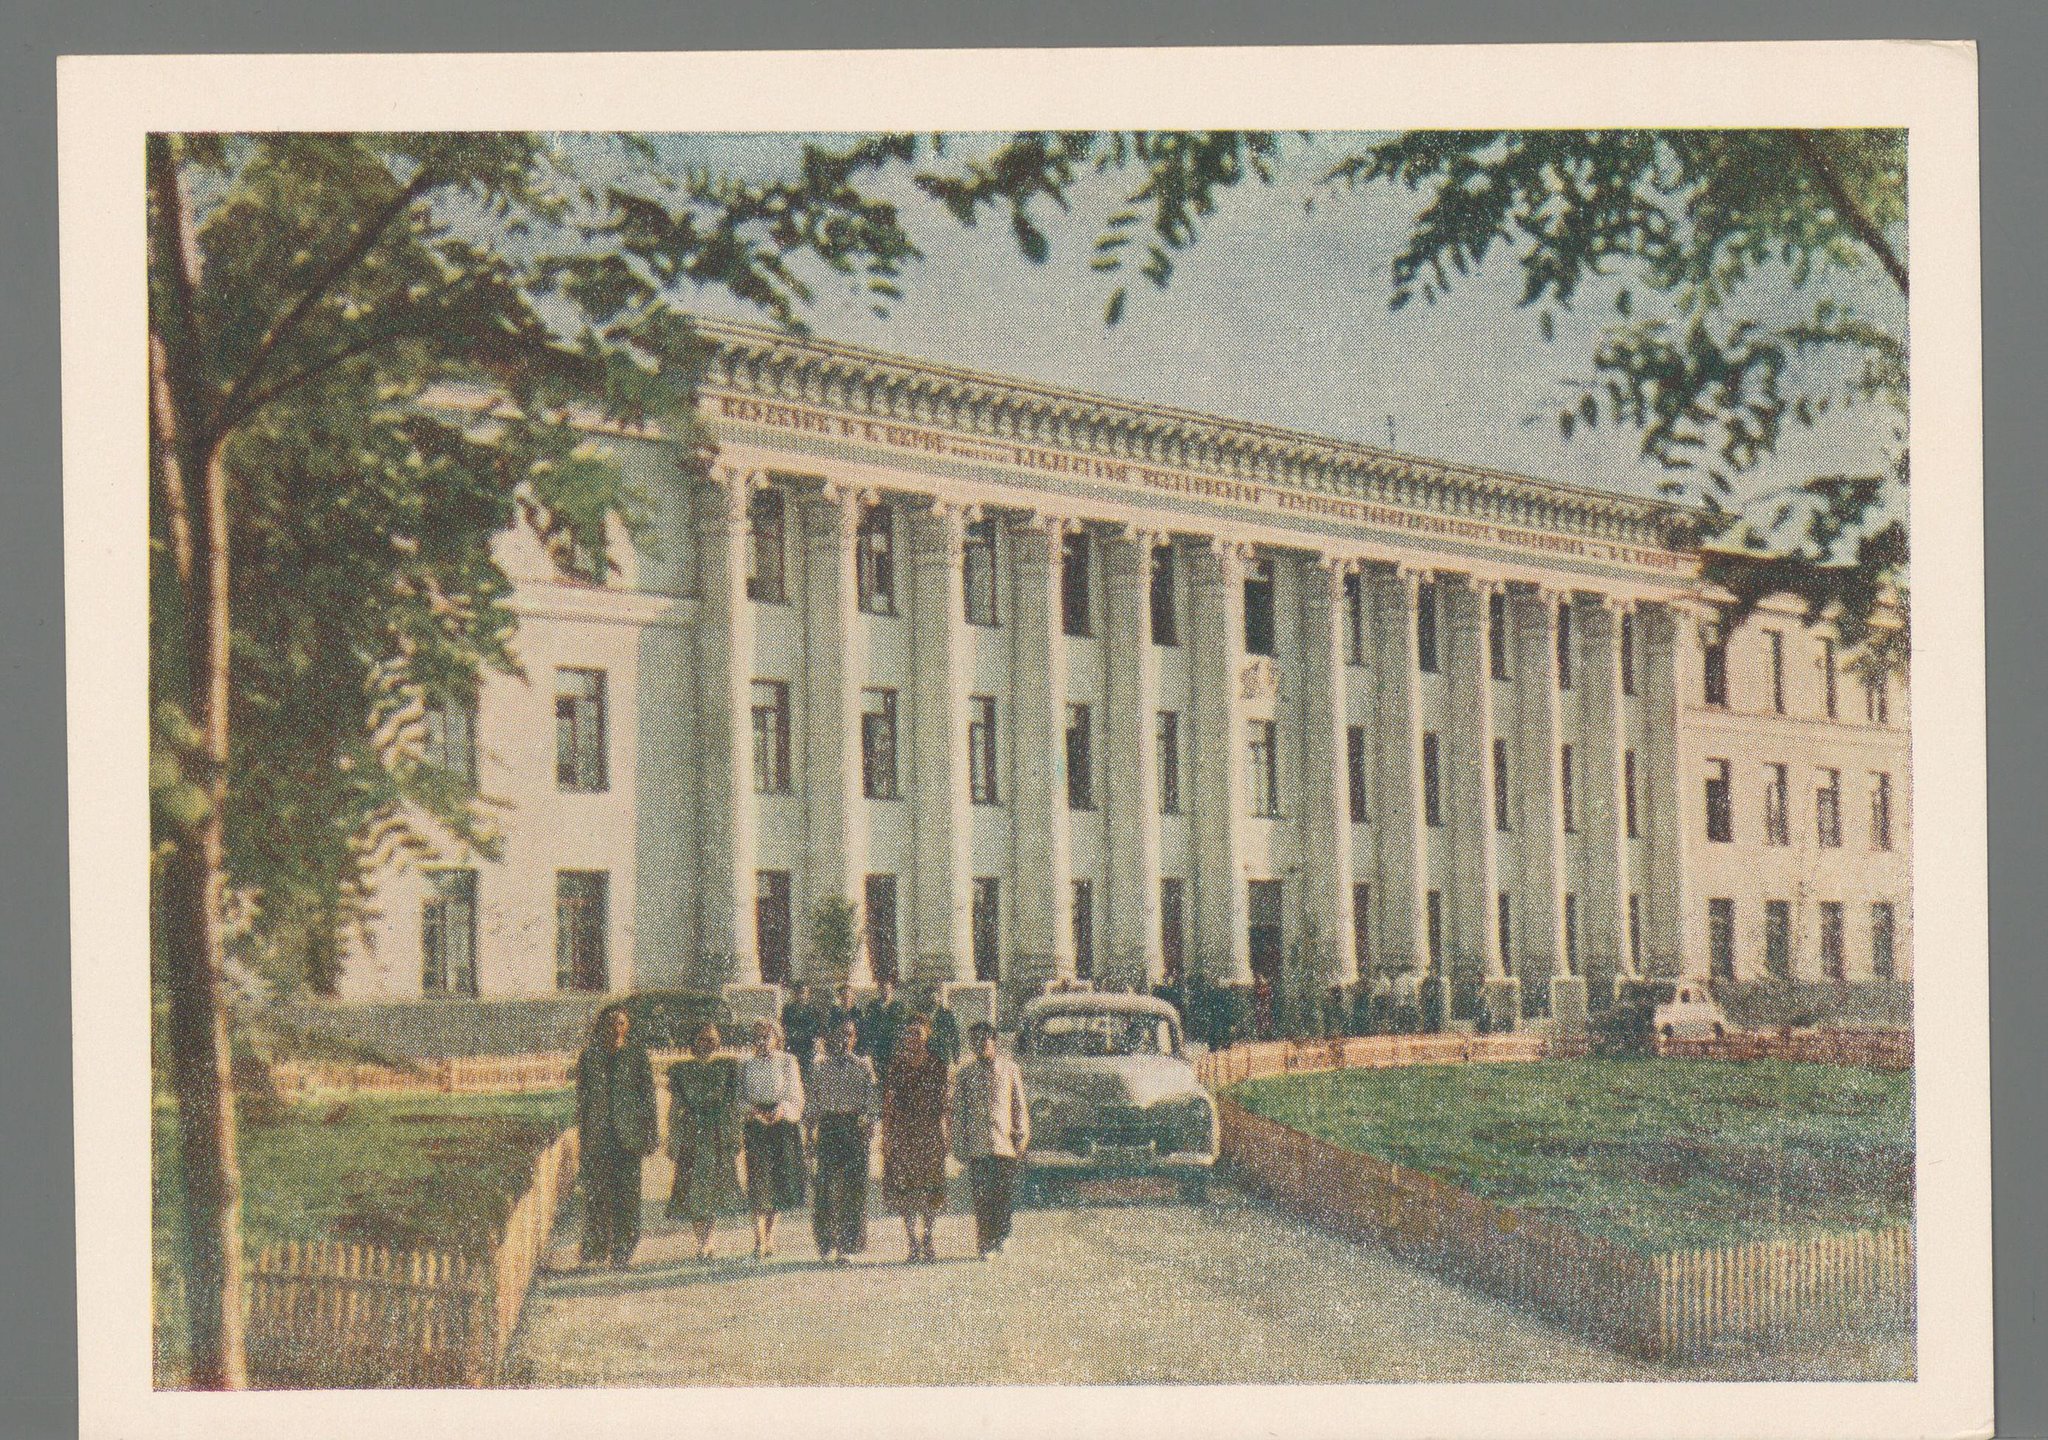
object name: ansichtkaart, prentbriefkaart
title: Kazakh S.S.R. Alma-Ata. Kirov State University / R.S.S. de Kazakhie. Alma-Ata. Université Kirov / Kasachische SSR. Alma-Ata. Kirow-Staatsuniversität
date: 1956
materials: cardboard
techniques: color autotype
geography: alma-ata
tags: university building, college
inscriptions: date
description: De titel op object staat ook in het Russisch.